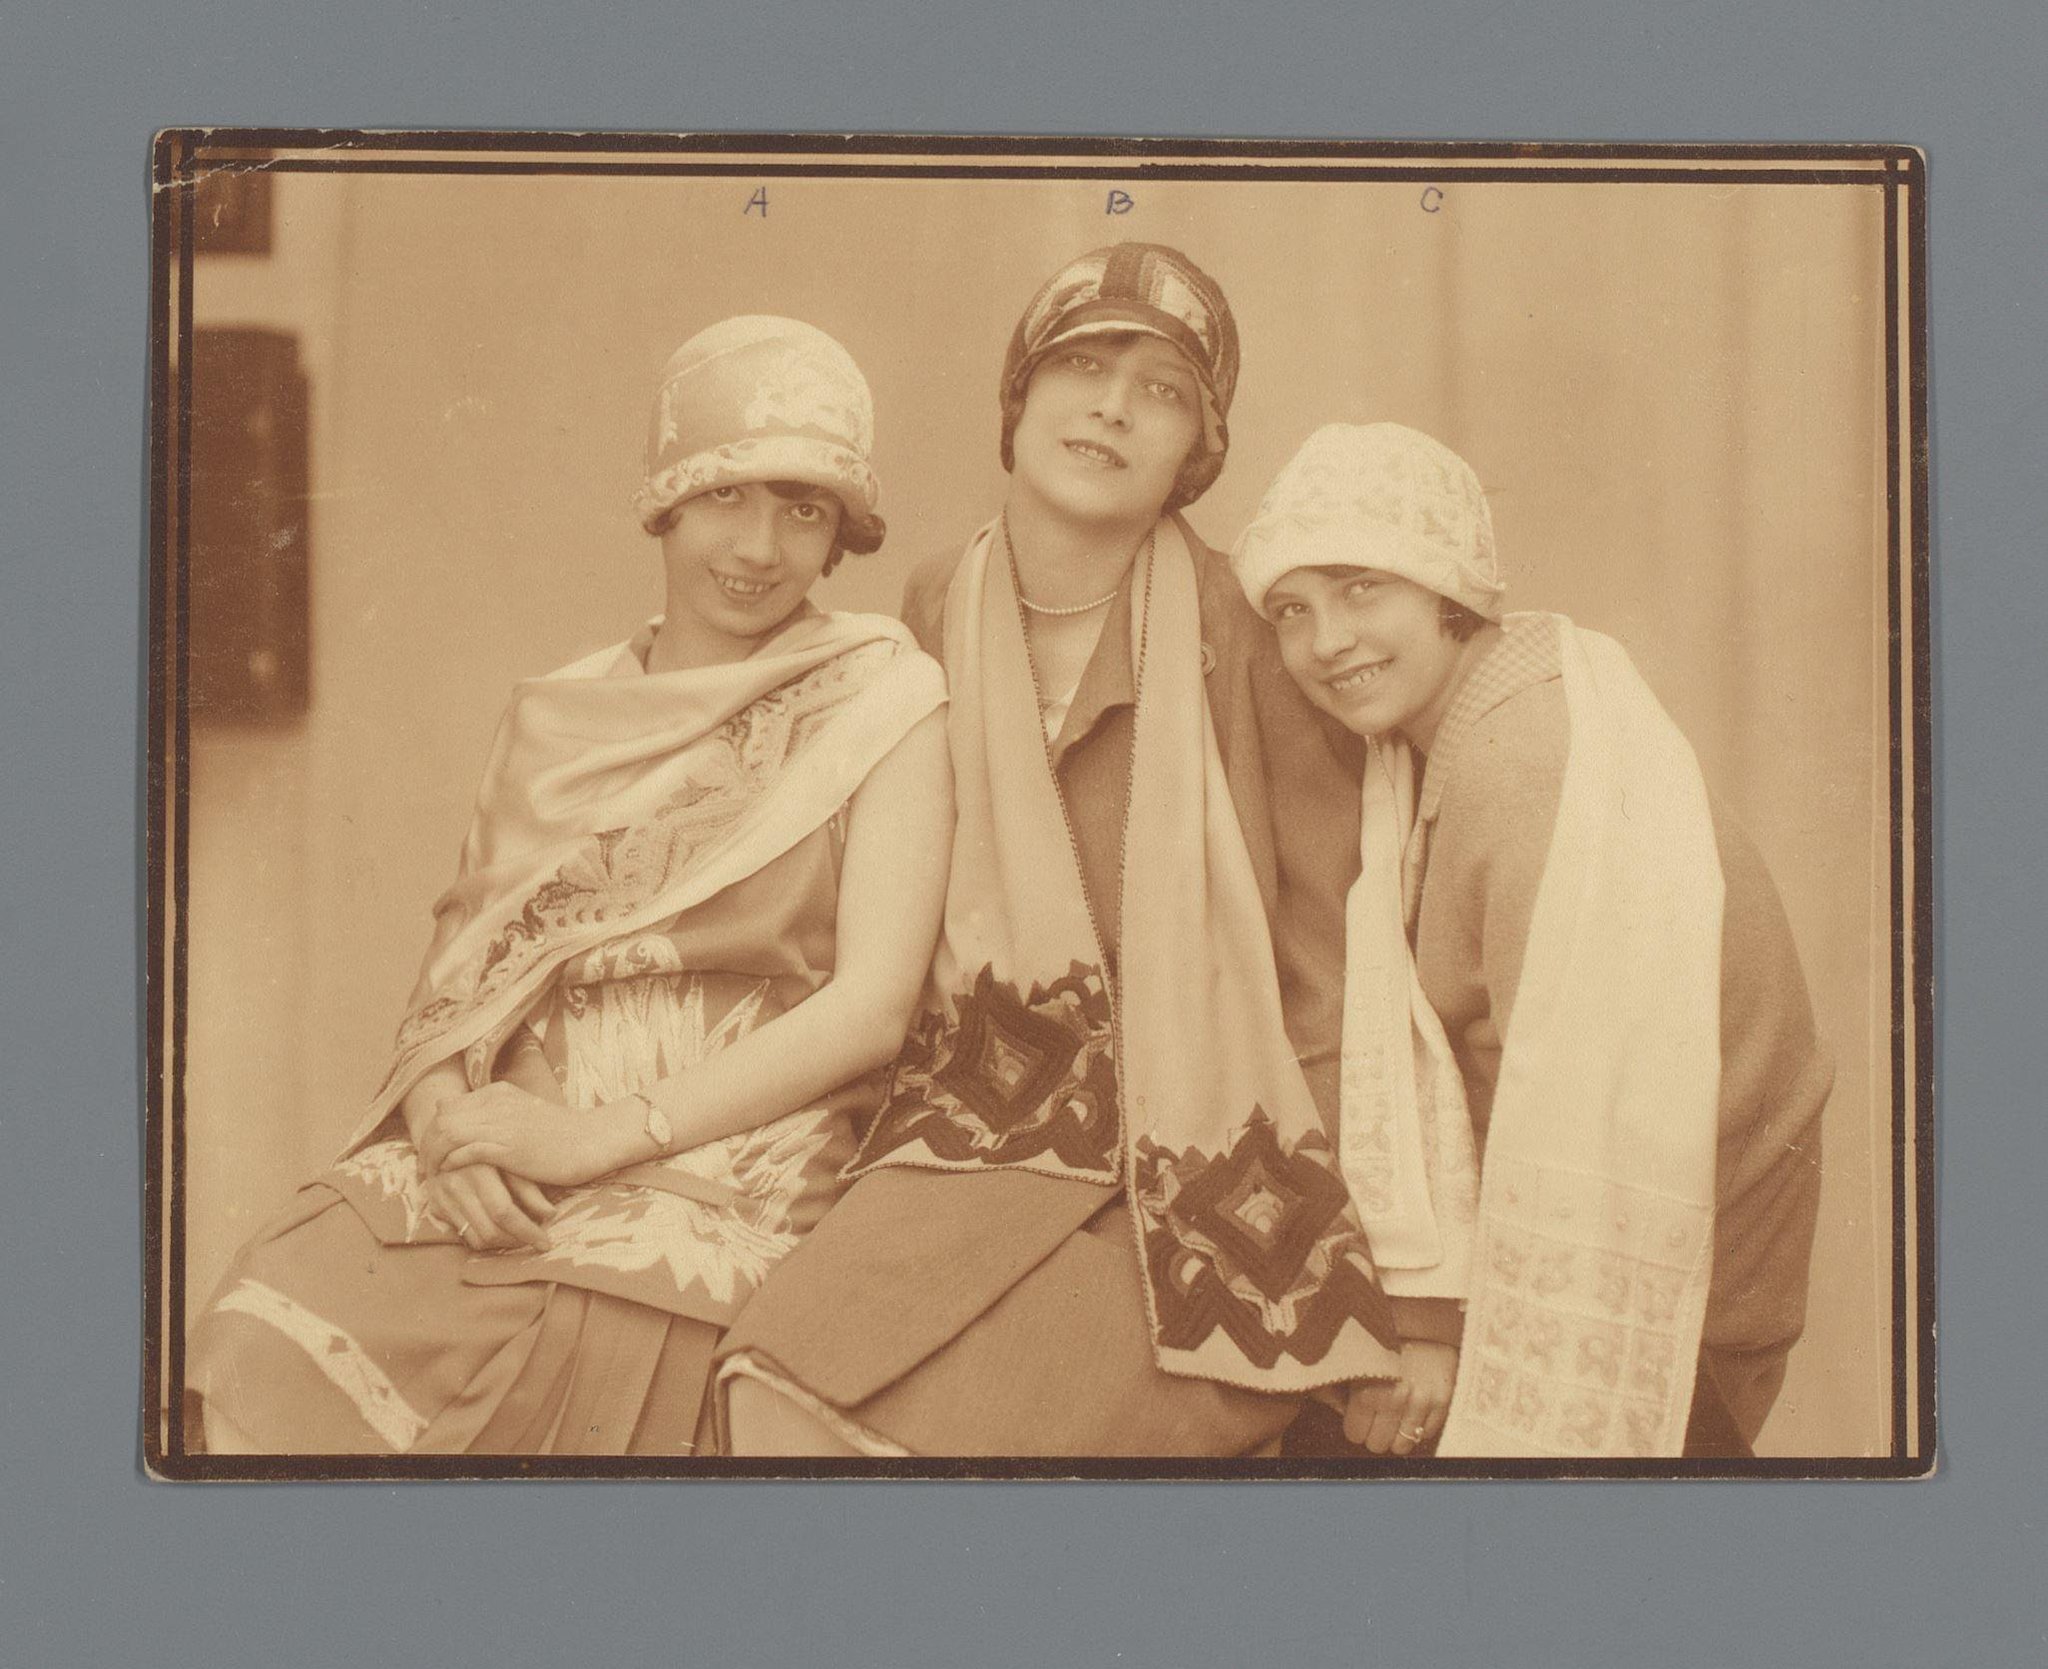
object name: photograph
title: Drie modellen met geborduurde jurken, sjaals, mantels en mutsen van de Wiener Werkstätte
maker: Anonymous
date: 1920-1930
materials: photographic support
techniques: gelatin silver print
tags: fashion plates, dress, gown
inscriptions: inscription: ‘130-24’, number: ‘24’, inscription